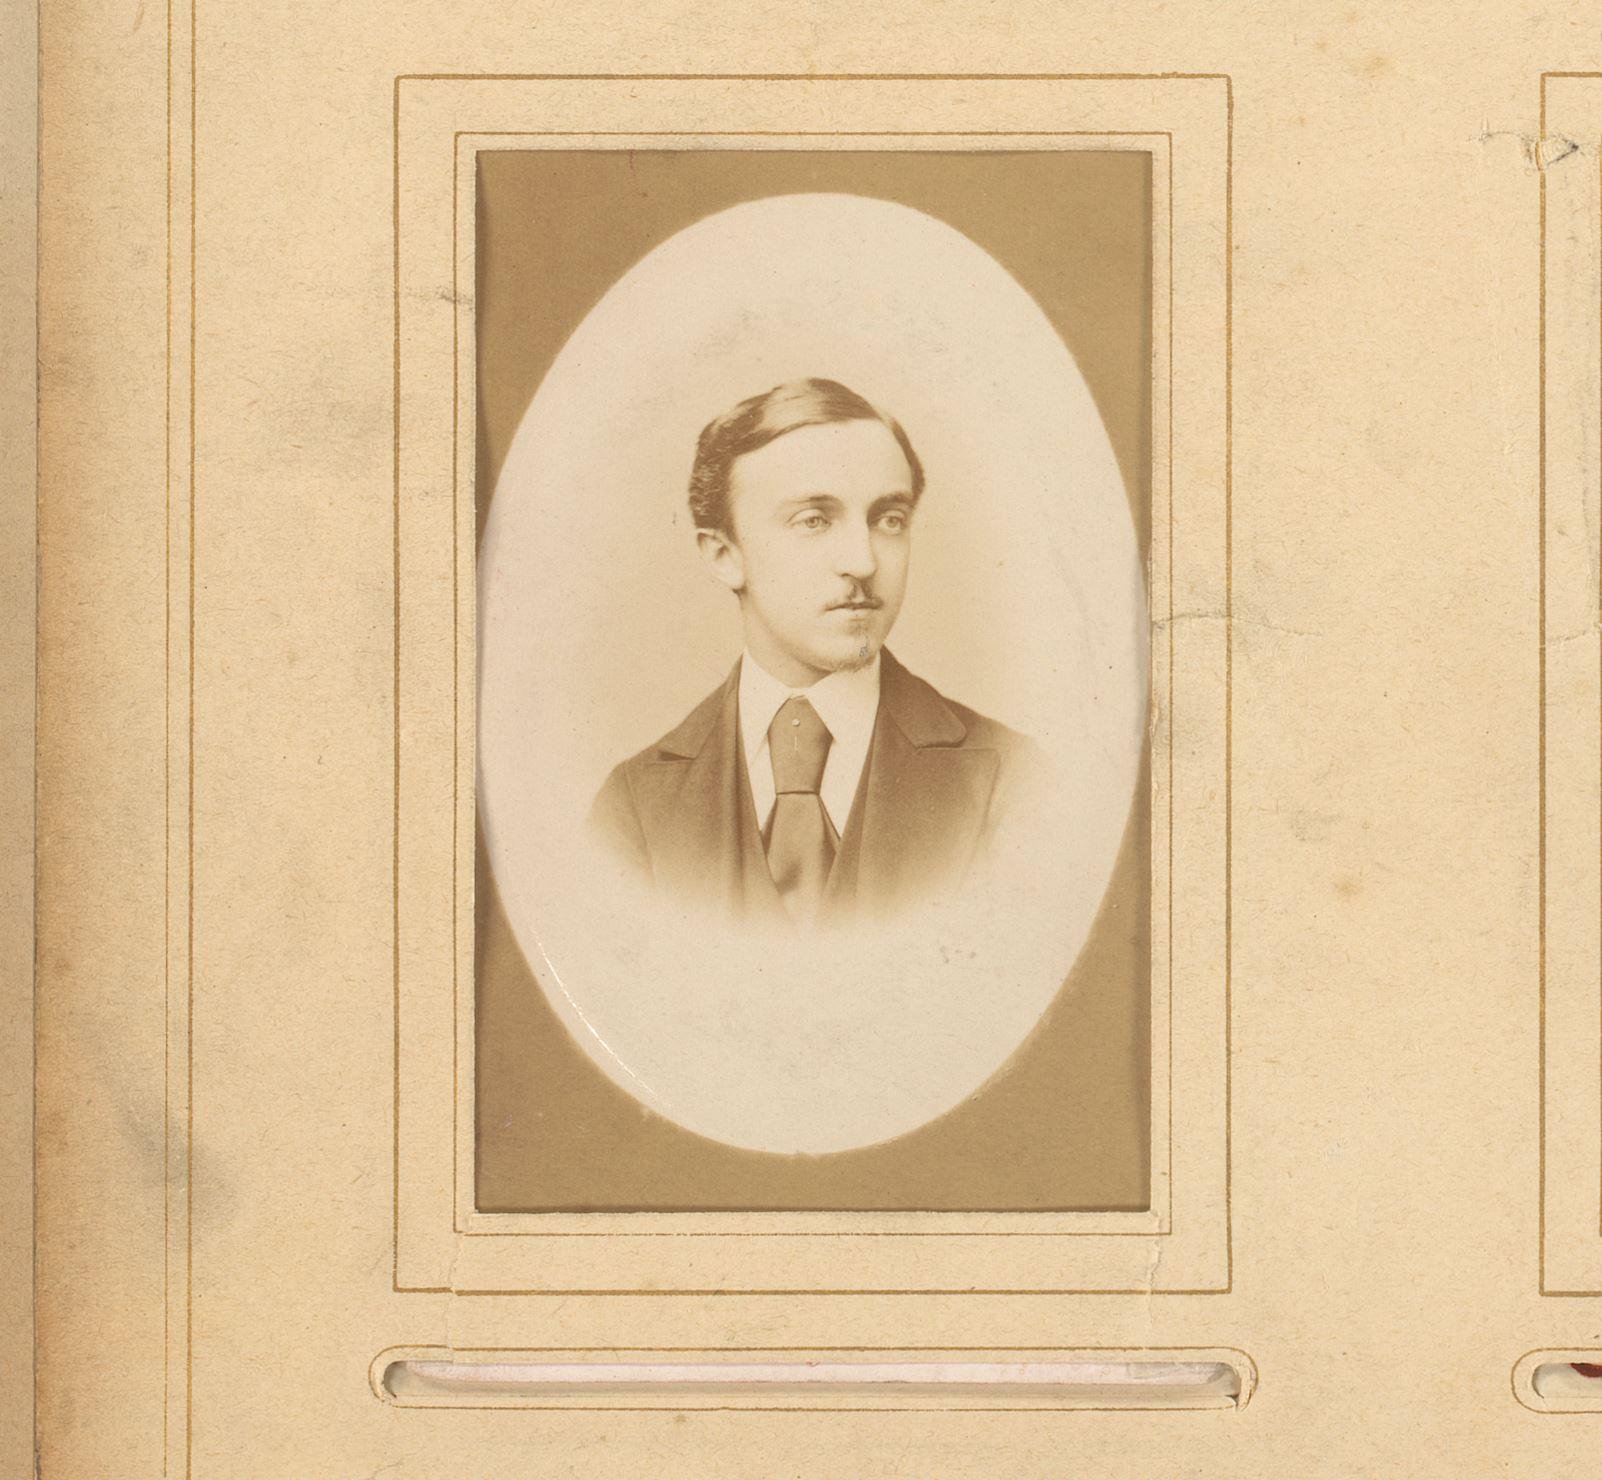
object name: carte de visite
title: Portret van een jonge man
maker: walter bradnee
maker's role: fotograaf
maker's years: 1817-1898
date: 1850-1900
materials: cardboard, photographic support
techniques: albumen print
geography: torquay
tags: historical persons, youth, adolescent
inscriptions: inscription: ‘W. Bradnee,/ Torquay./ &/ Calabria/ Newton Abbot.’